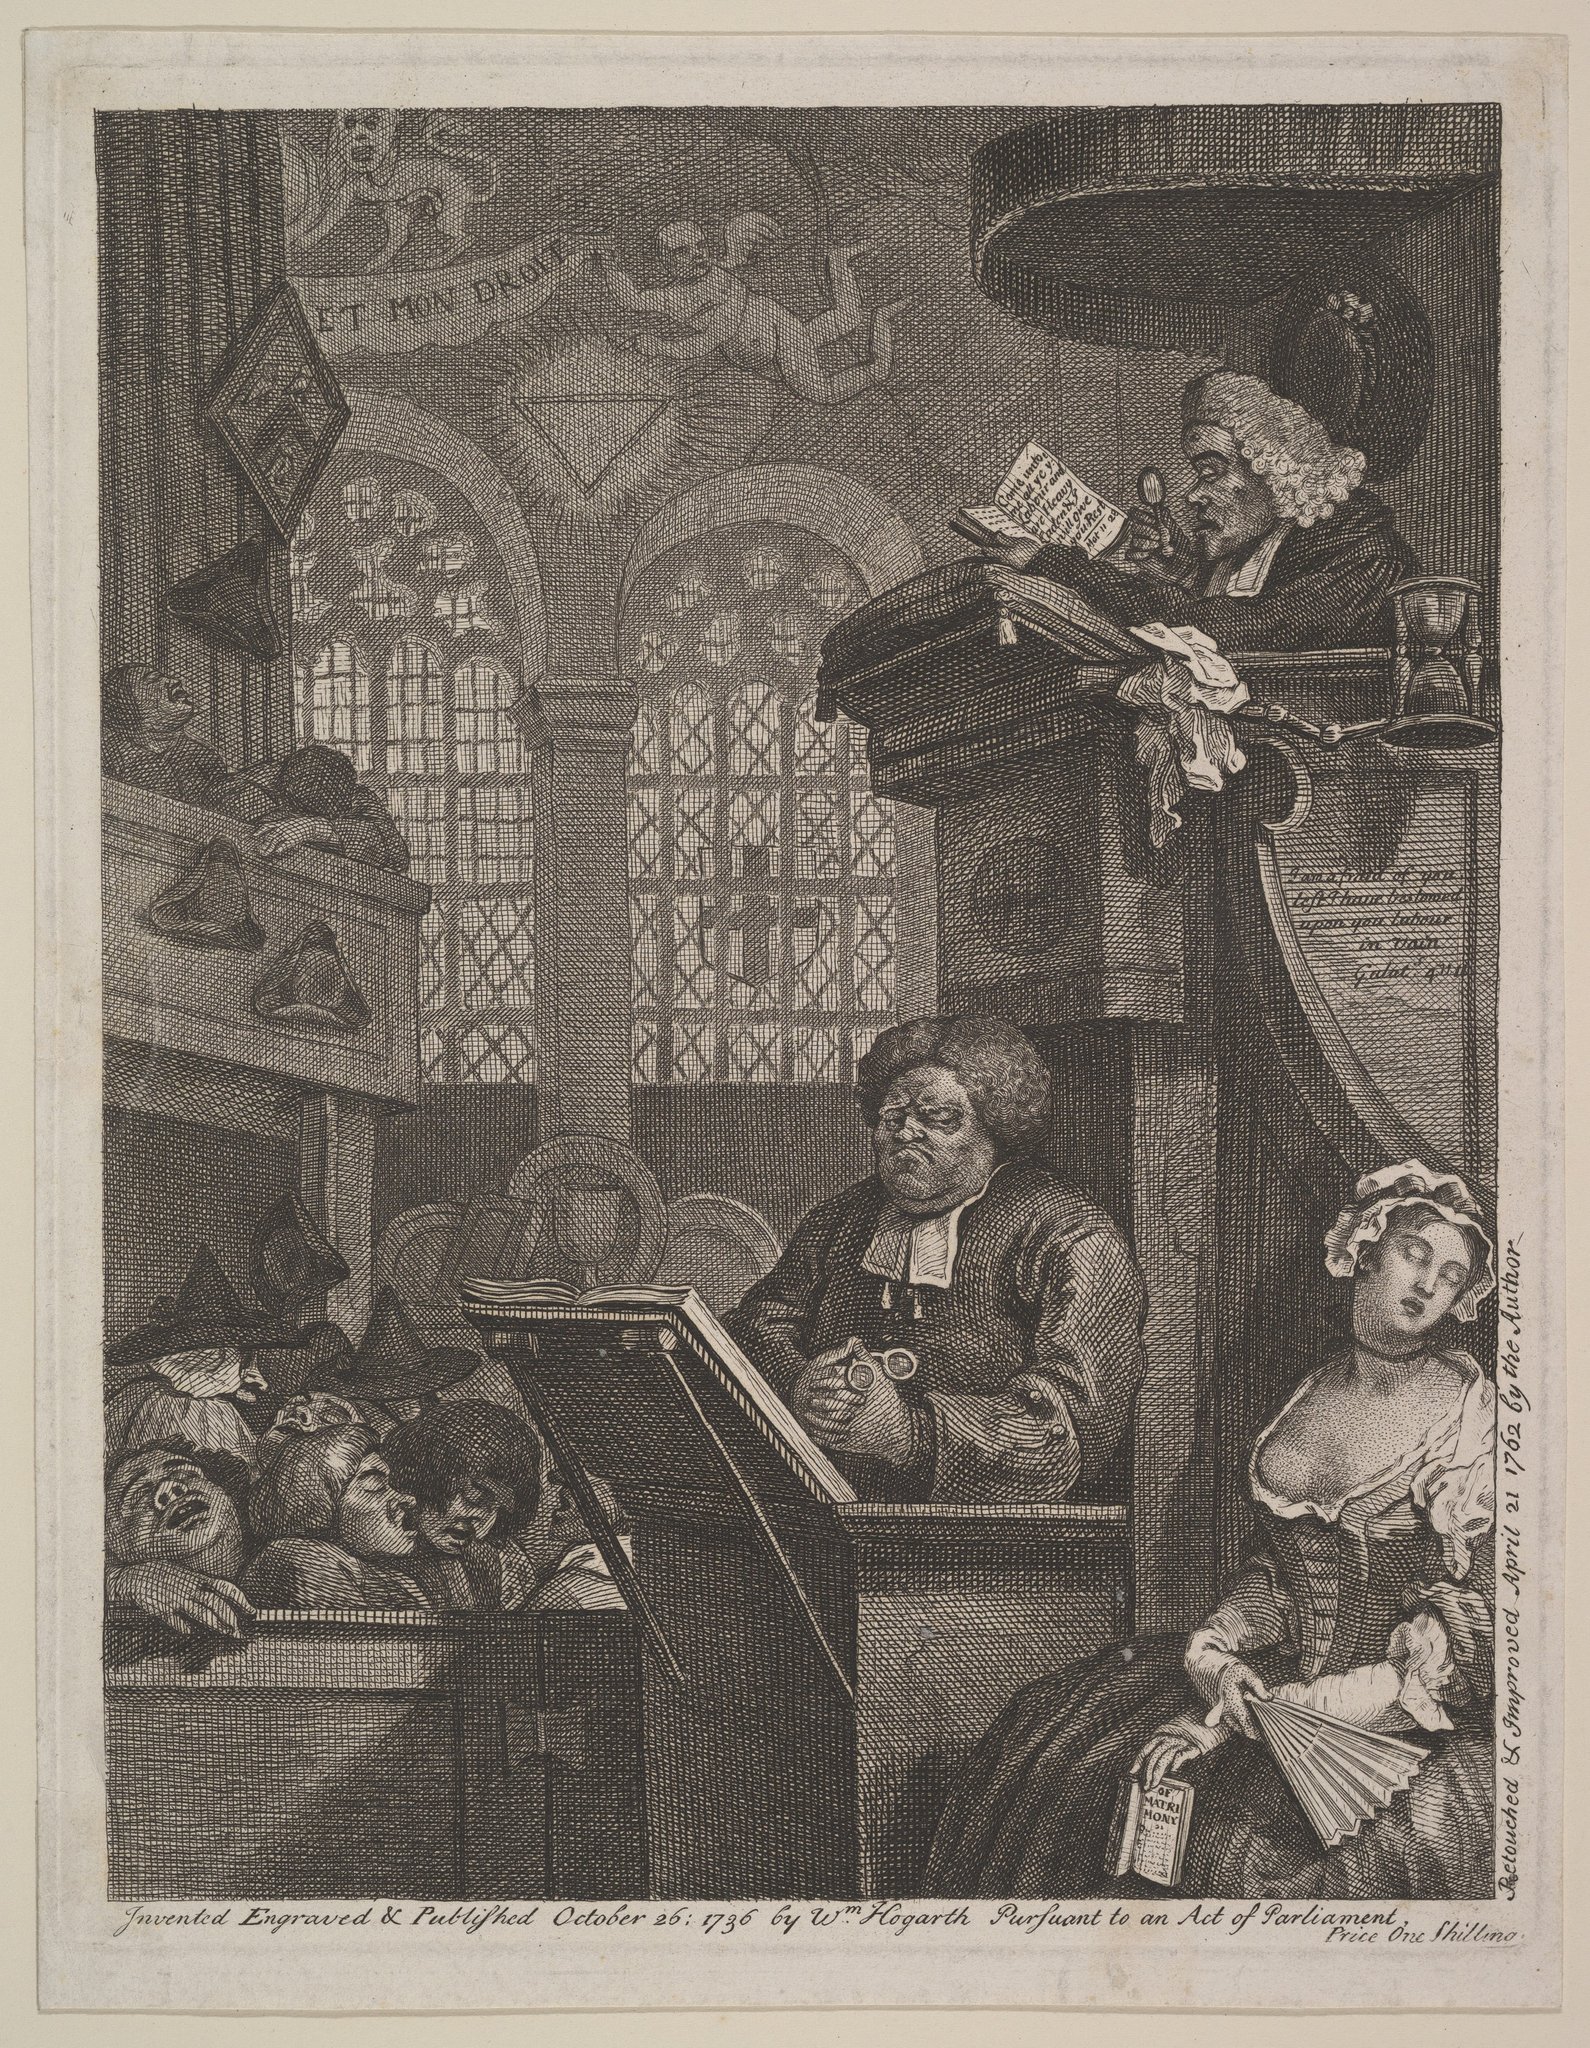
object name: print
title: The Sleeping Congregation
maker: william hogarth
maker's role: artist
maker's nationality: british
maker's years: 1697-1764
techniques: engraving, etching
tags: sleeping,men,women,reading,praying